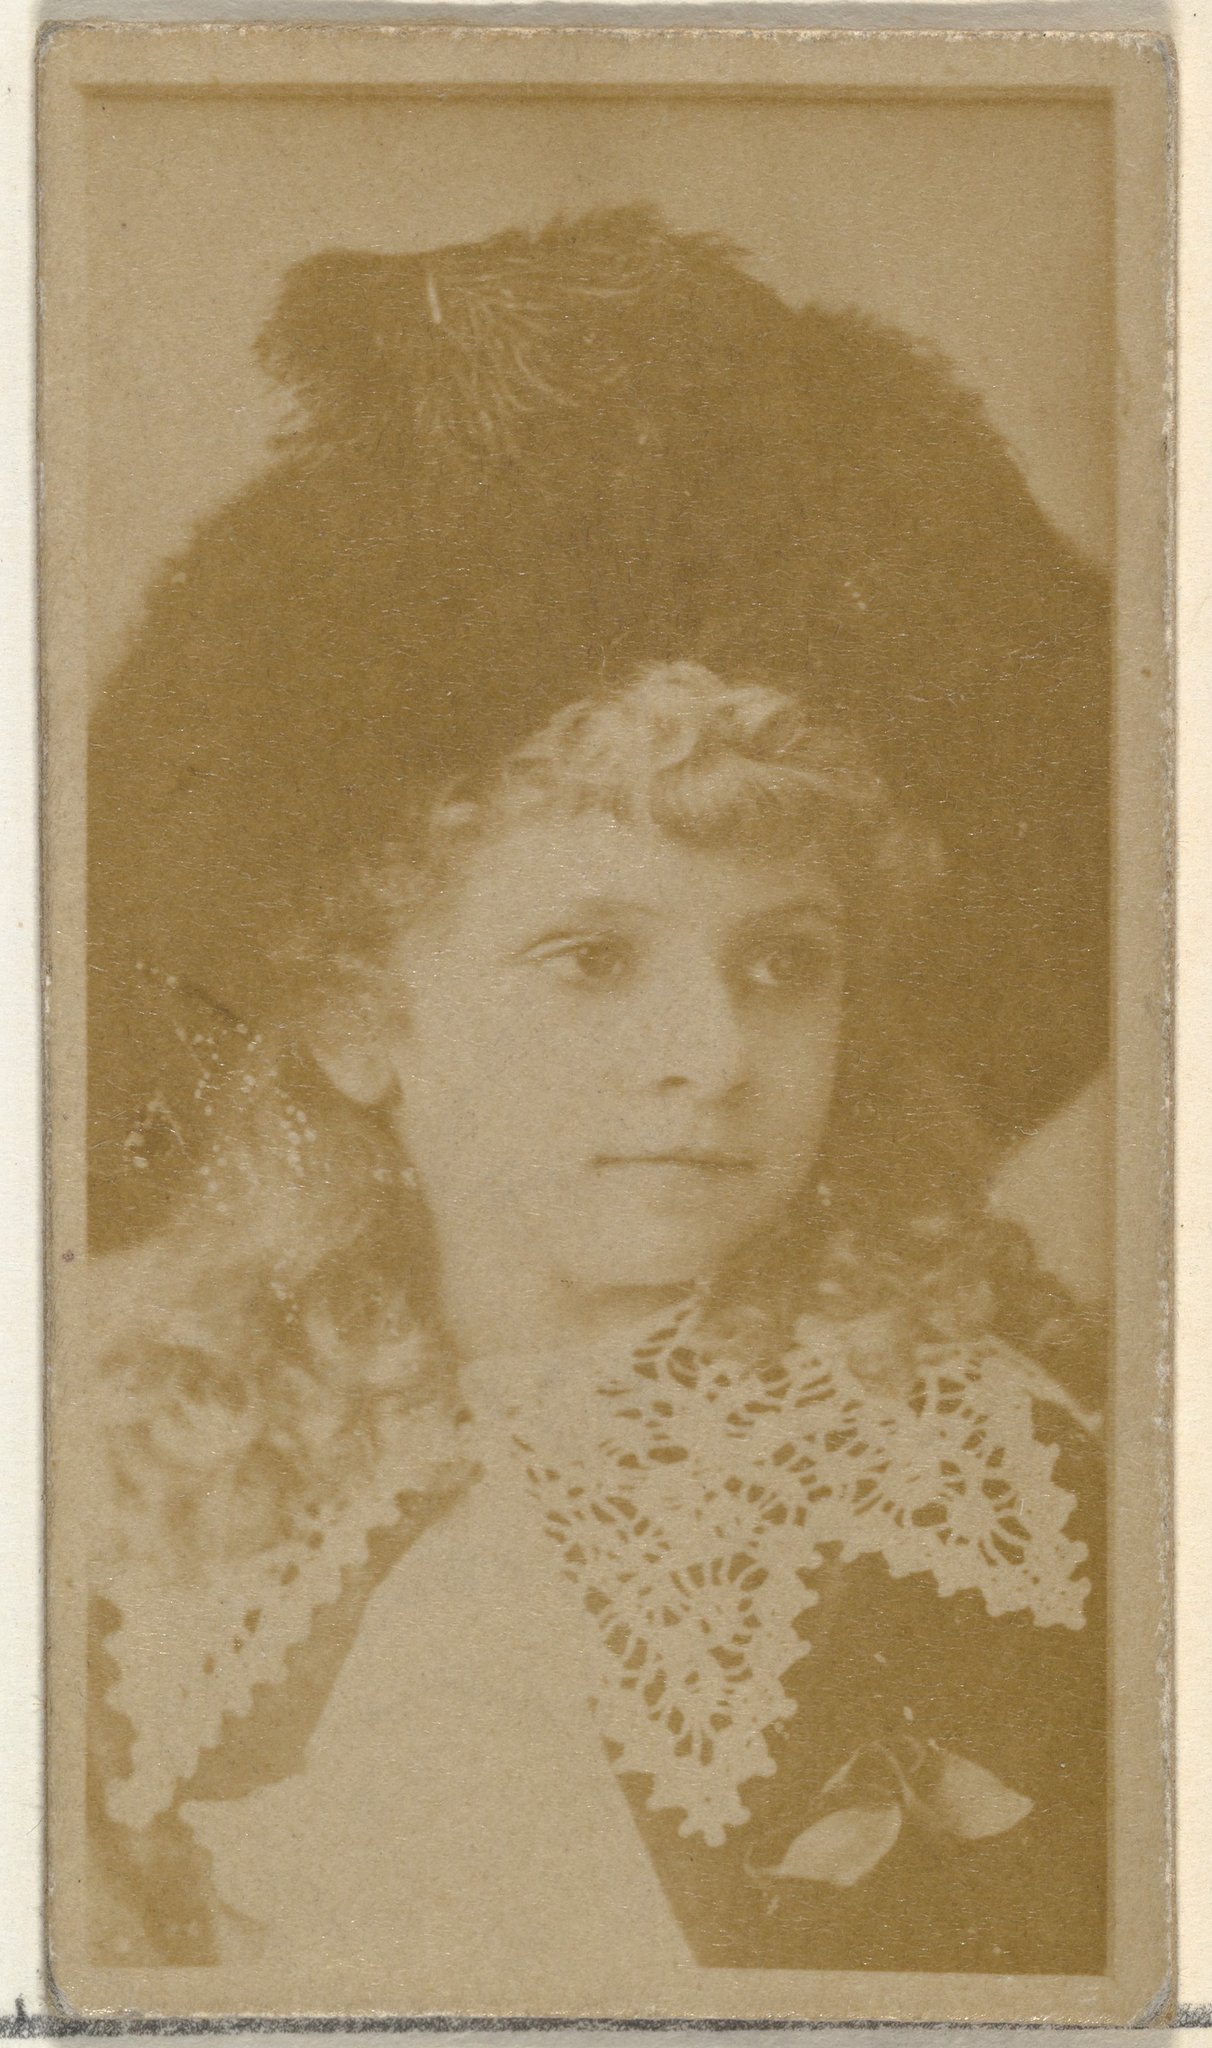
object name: photograph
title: [Actress wearing dress with ornate lace collar], from the Actors and Actresses series (N145-8) issued by Duke Sons & Co. to promote Duke Cigarettes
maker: w. duke, sons & co.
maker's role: publisher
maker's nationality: american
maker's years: 1870-1920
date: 1891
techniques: albumen silver print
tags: girls,portraits,actresses